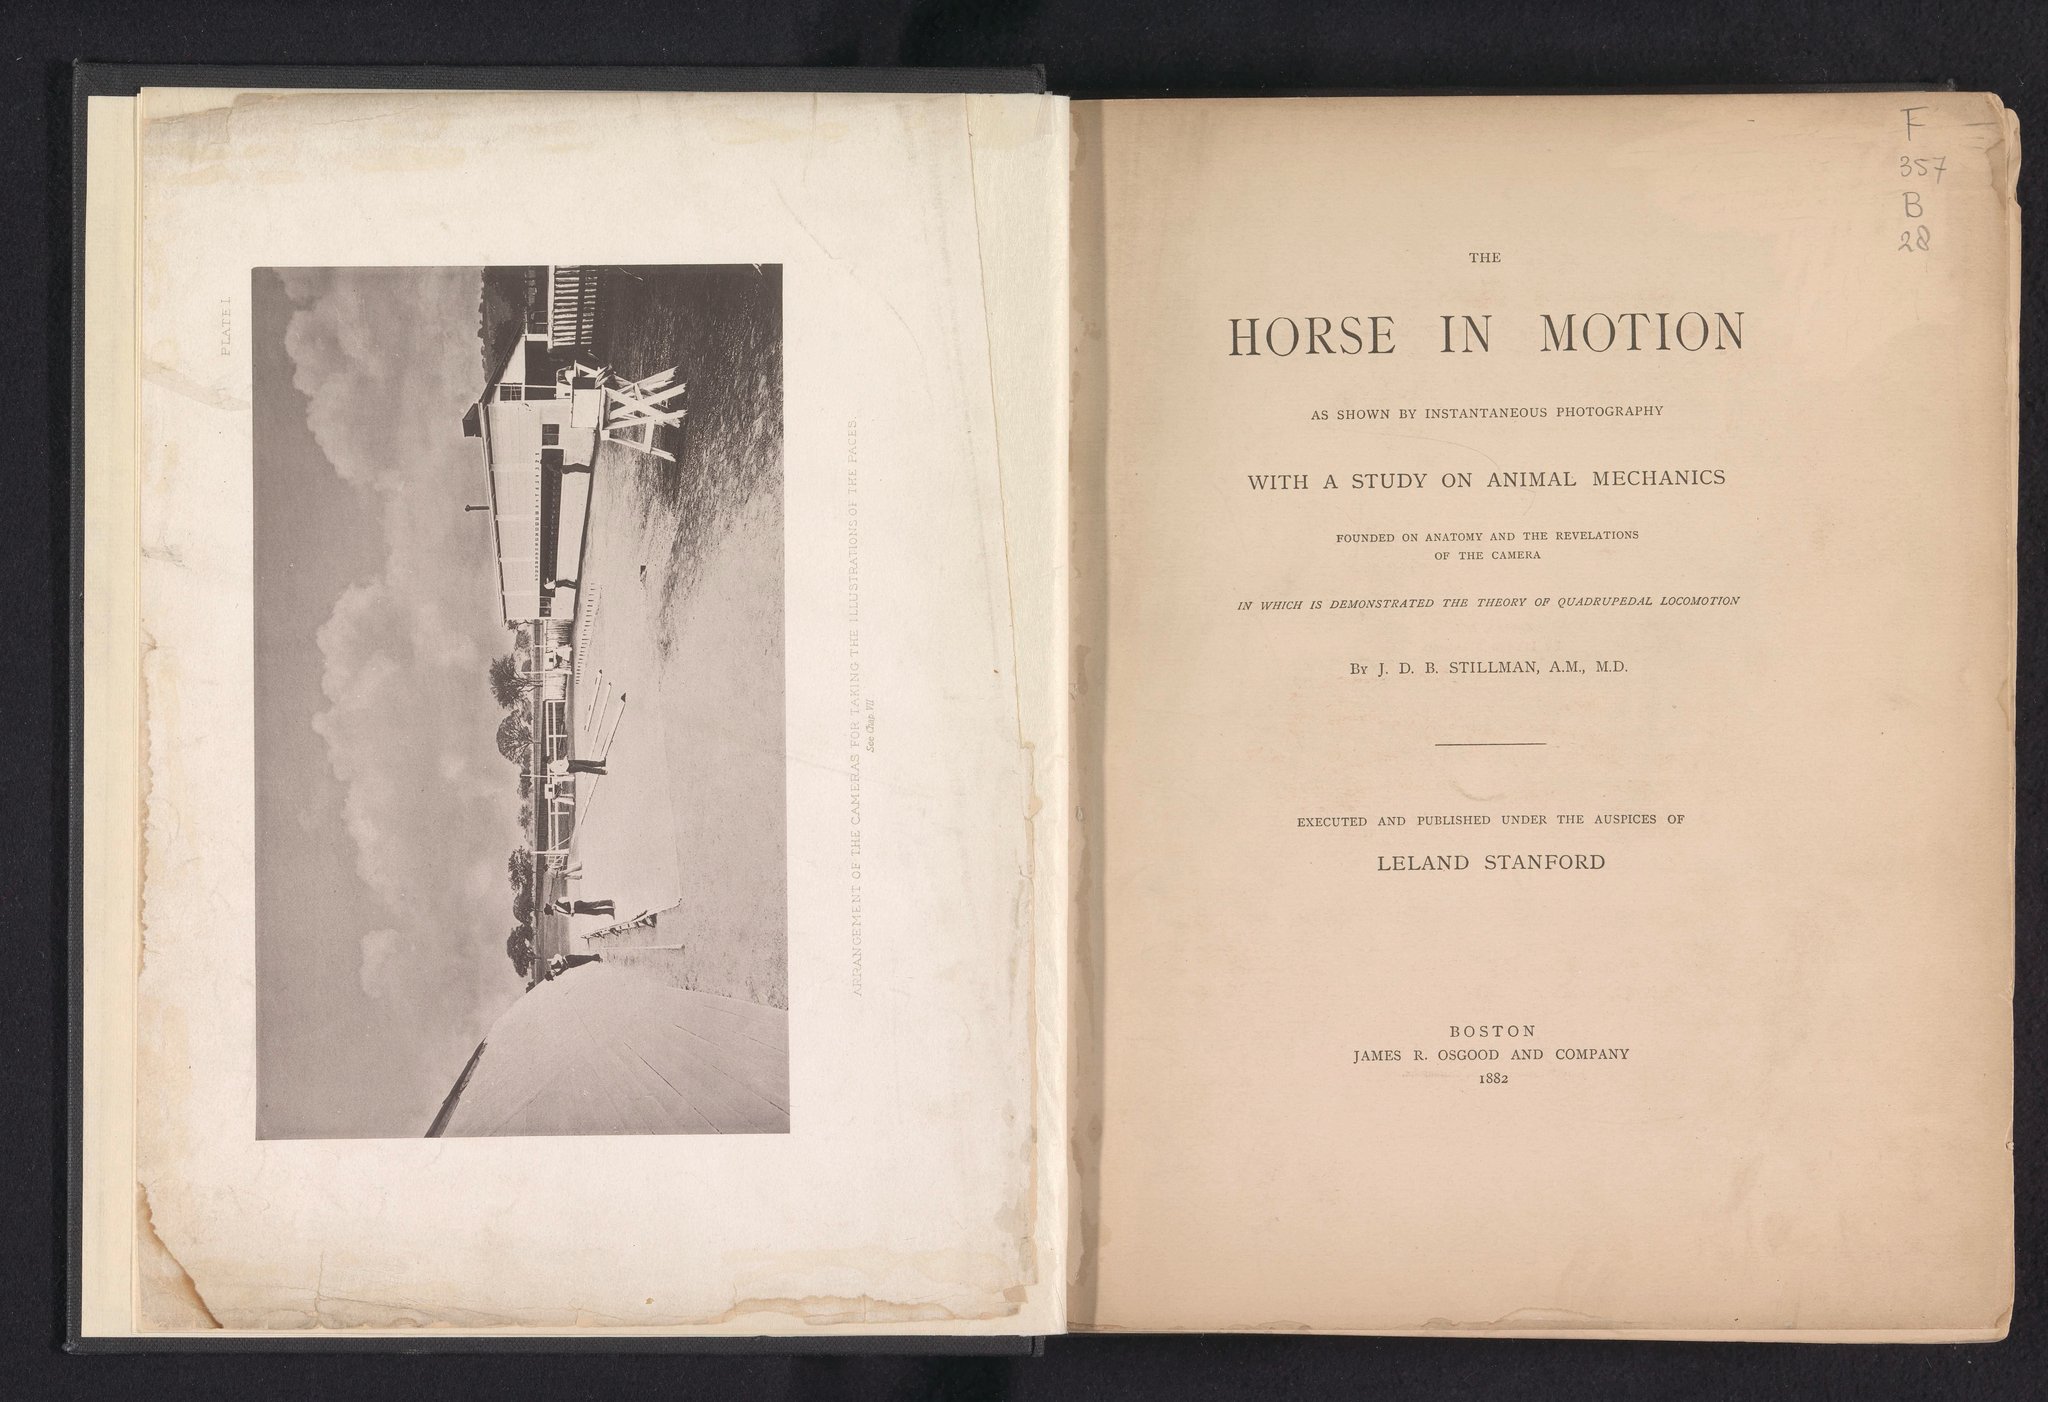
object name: book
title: The horse in motion as shown by instantaneous photography with a study on animal mechanics founded on anatomy and the revelations of the camera in which is demonstrated the theory of quadrupedal locomotion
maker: j.d.b. stillman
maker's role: arts, schrijver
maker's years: 1819-1888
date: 1882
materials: cardboard, linen, paper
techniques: lithograph, photoaquatint, printing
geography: boston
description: Muybridge was involved in motion photography for 15 years. During that time, he used a variety of cameras and setups. These photos feature the track he used around 1880. Muybridge used 24 cameras in a row that could be operated sequentially. This allowd him to capture movement from different angles simultaneously.